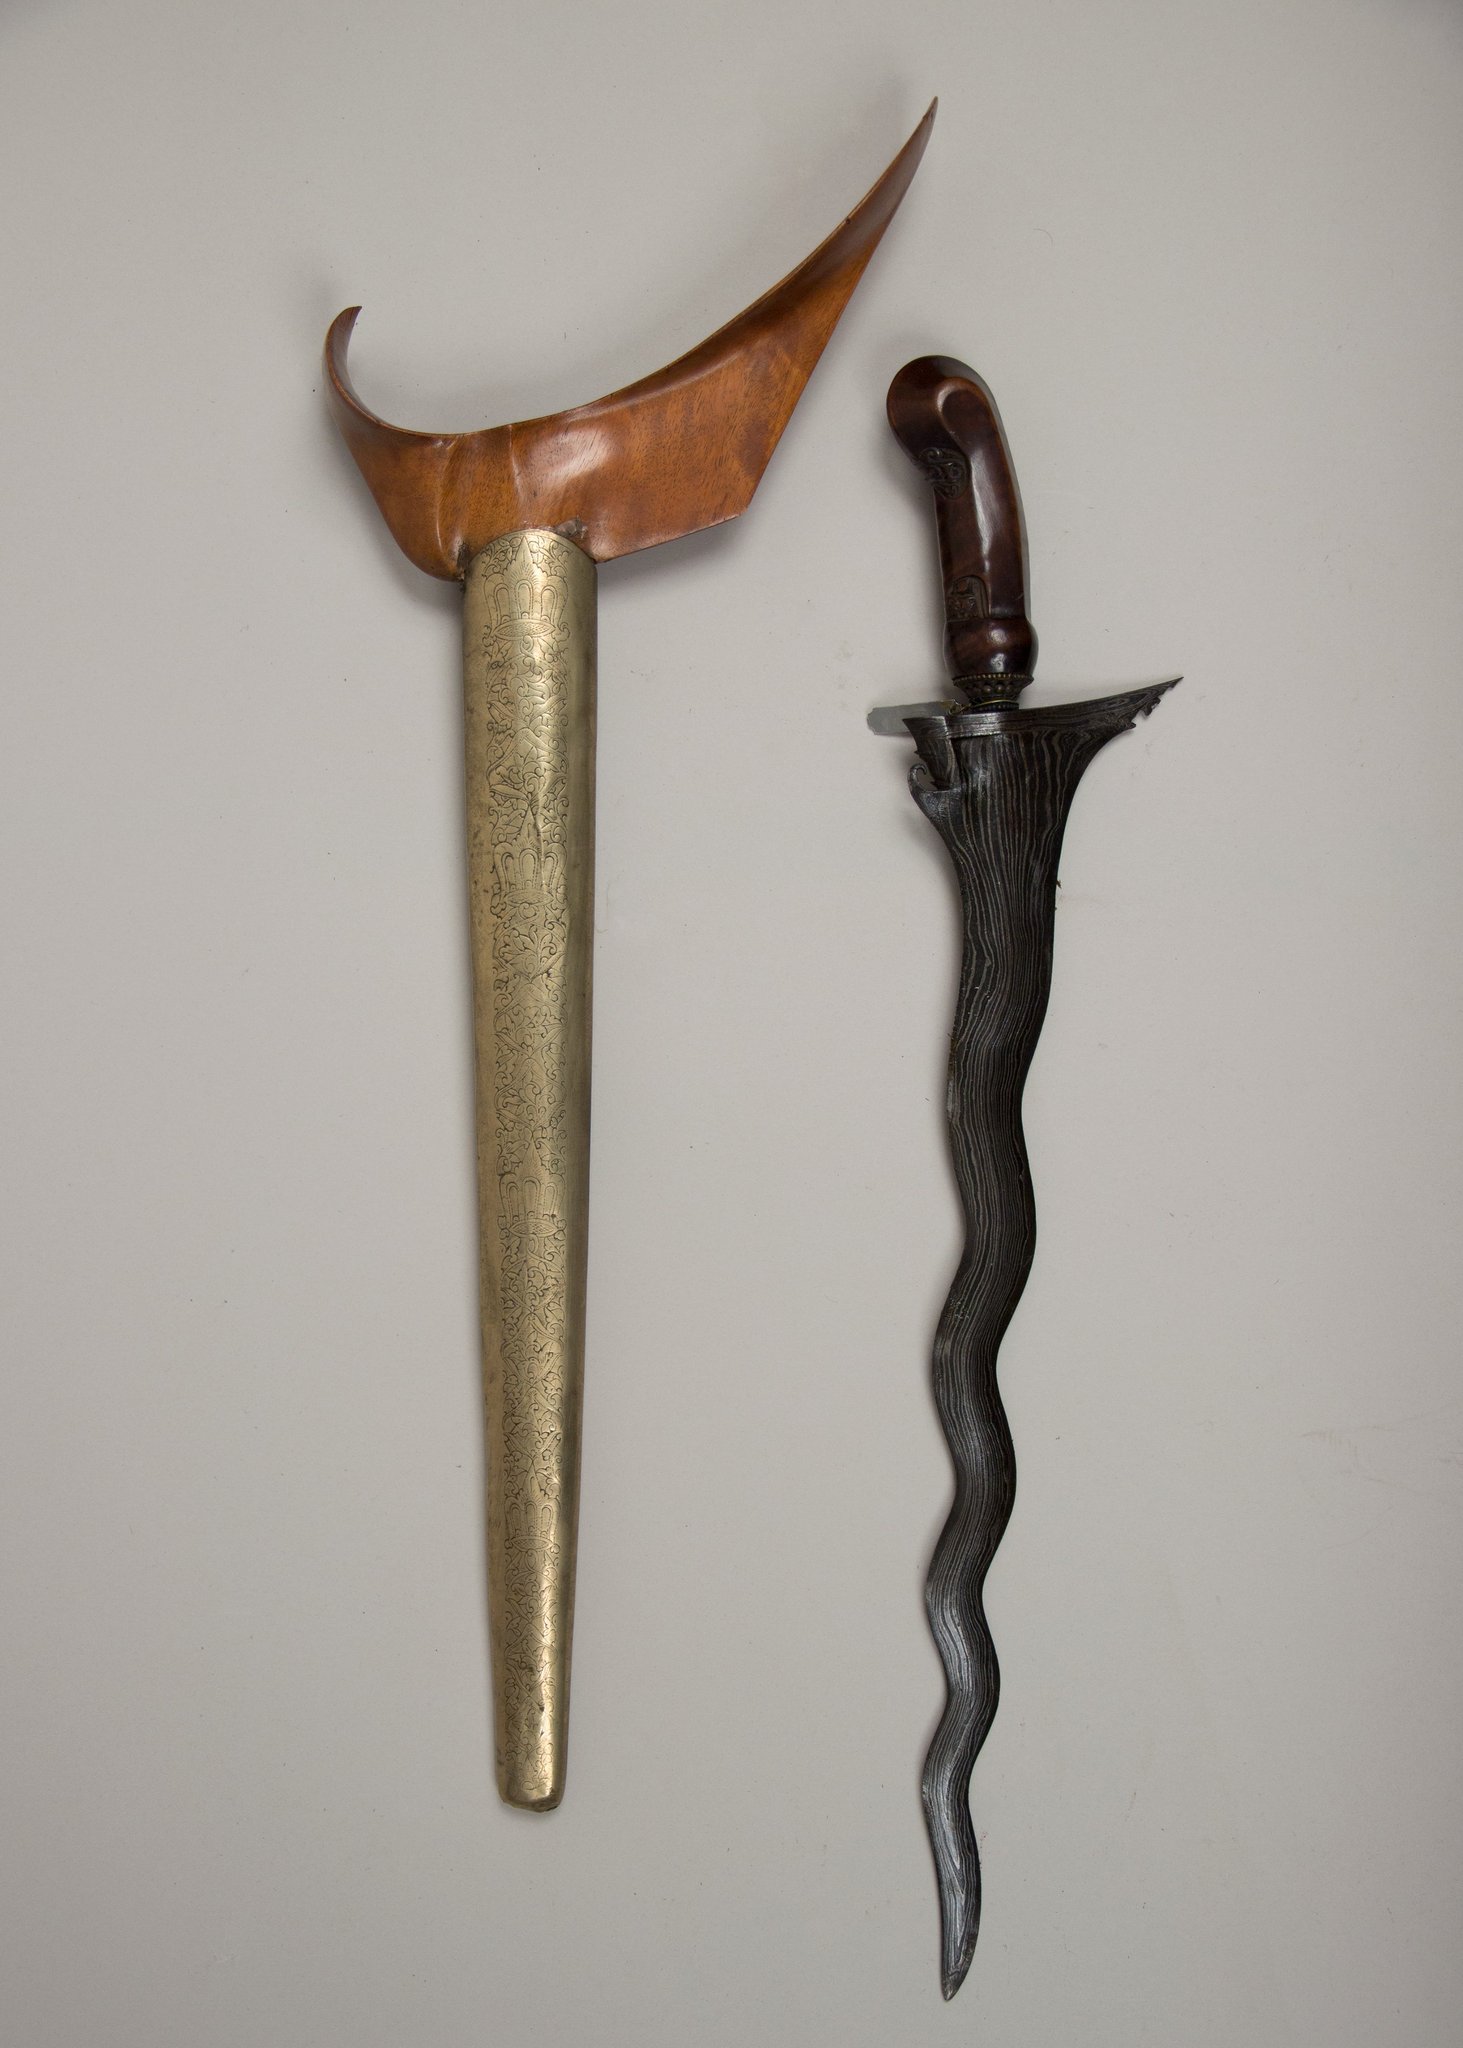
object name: kris with sheath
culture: javanese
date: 1501-1900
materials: brass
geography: indonesia